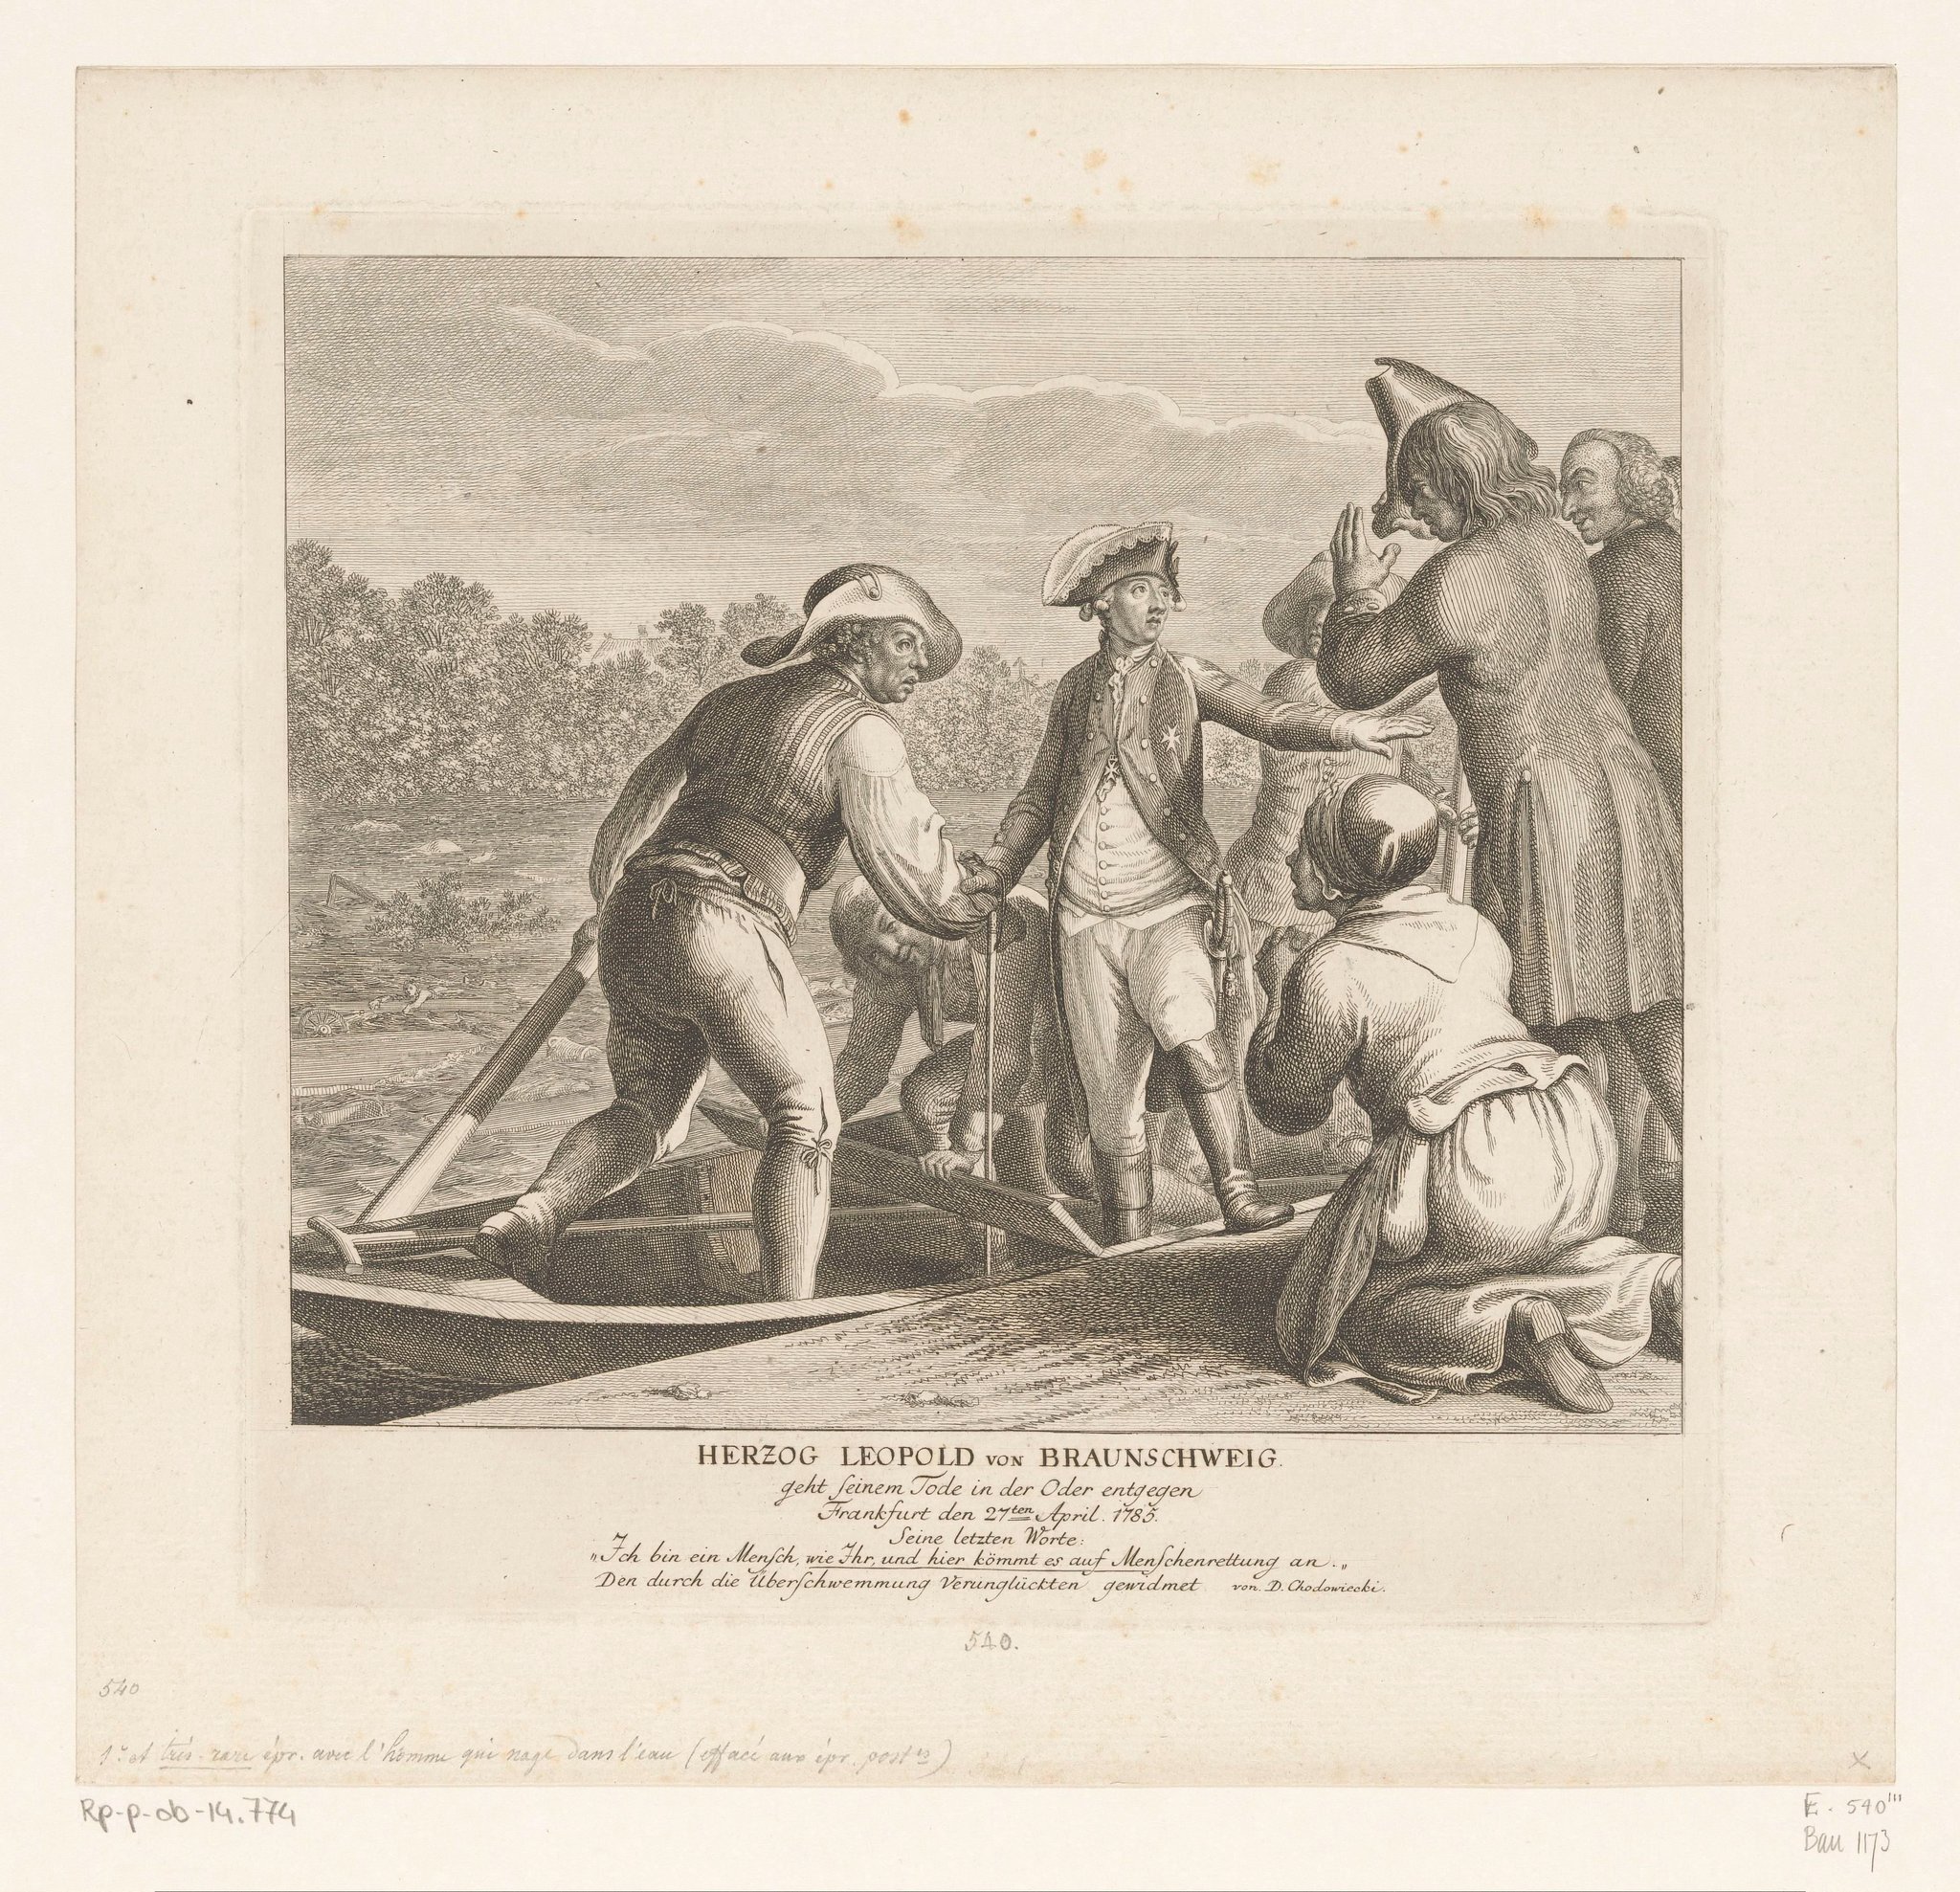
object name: print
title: Hertog Leopold von Braunschweig gaat zijn dood in de Oder tegemoet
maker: daniel nikolaus chodowiecki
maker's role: draughtsman, print maker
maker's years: 1726-1801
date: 1785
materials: paper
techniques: etching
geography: berlin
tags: rescue work during a flood, historical persons, rowing-boat, canoe, etc., waving farewell ~ departure on a journey, death of human being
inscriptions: collector's mark: Lugt 2228